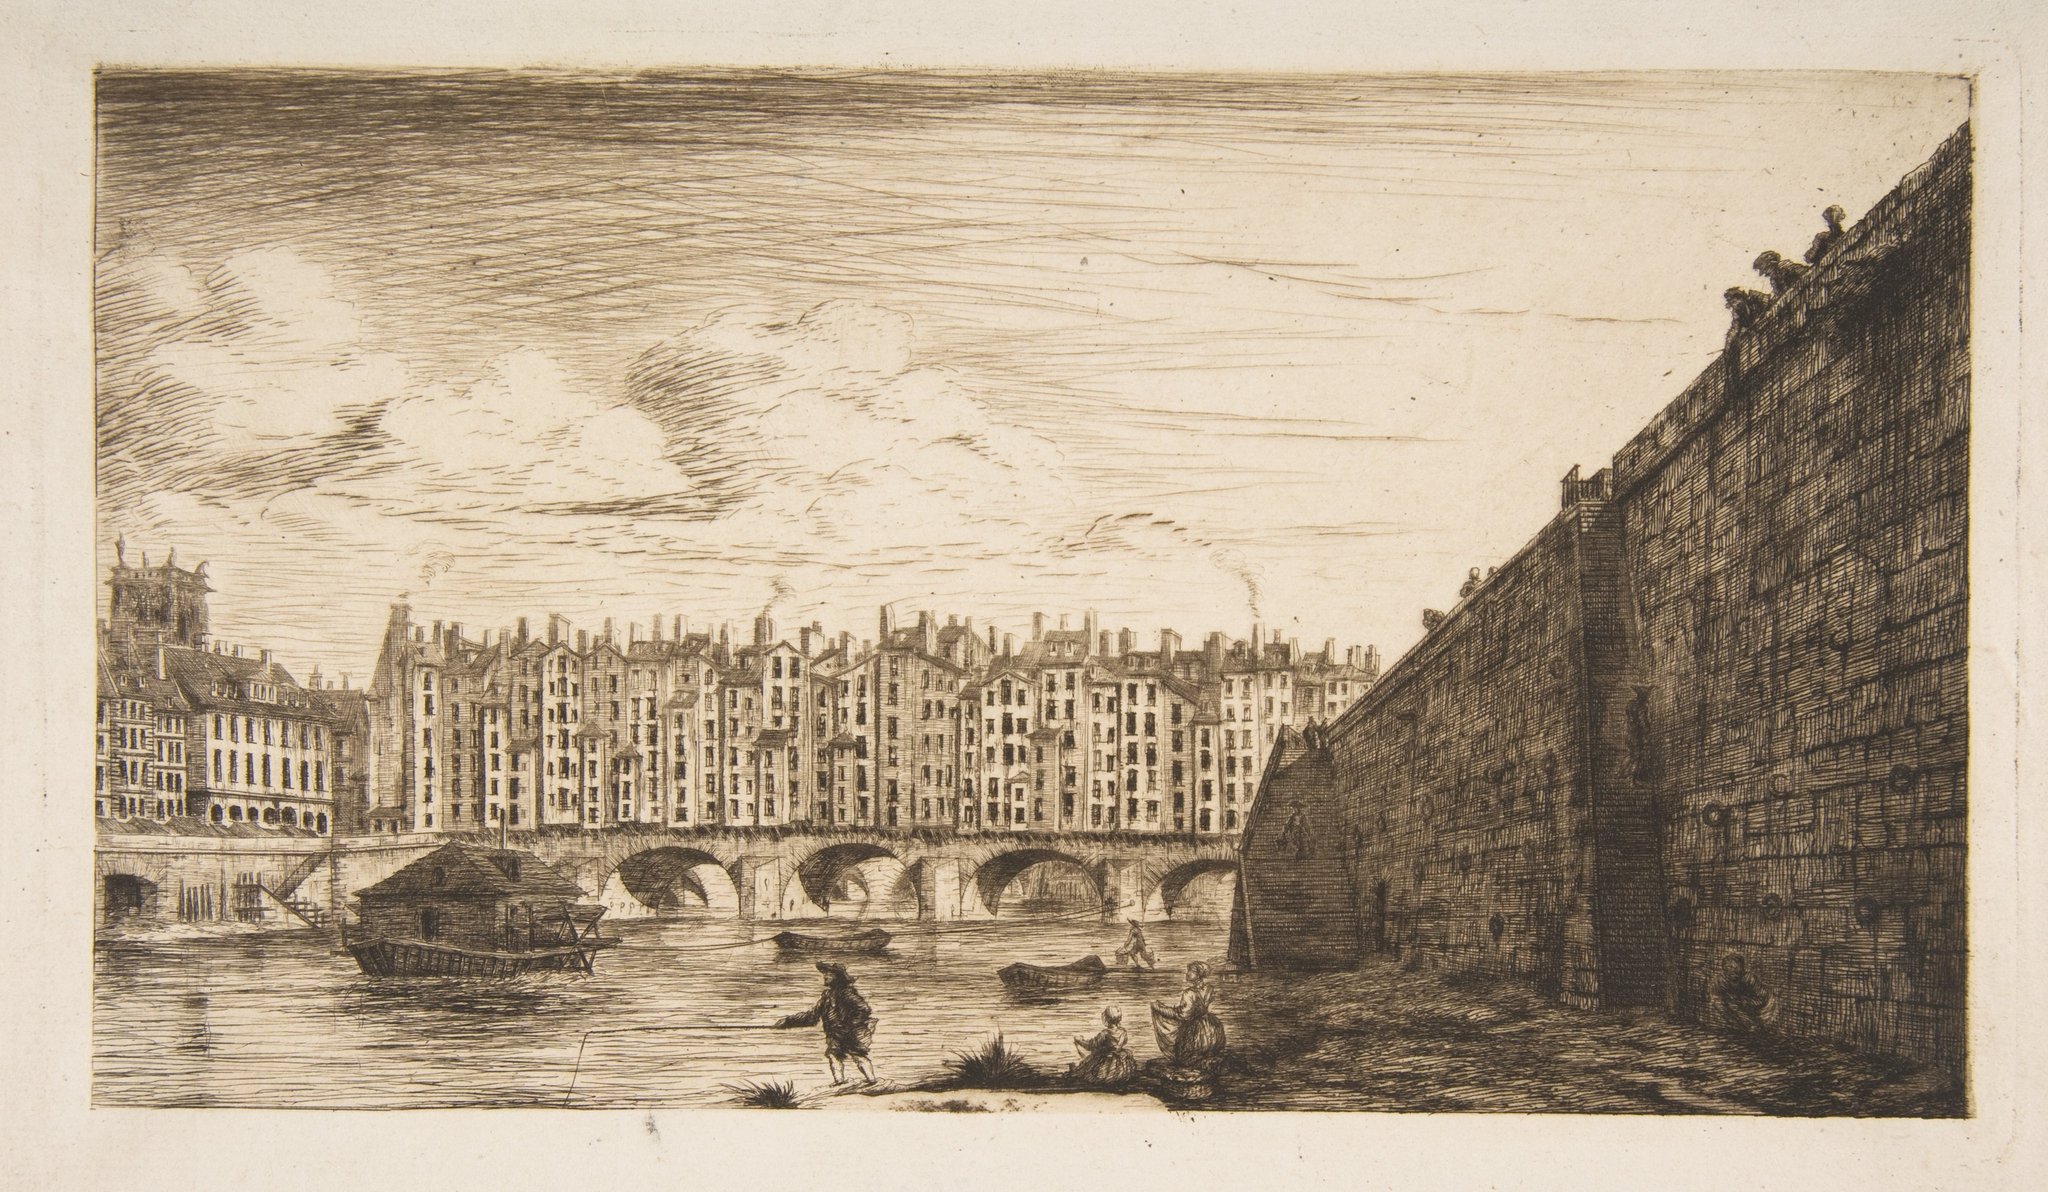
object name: print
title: Le Pont-au-Change, vers 1784 (Pont-au-Change, Paris, circa 1784)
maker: charles meryon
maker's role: artist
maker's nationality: french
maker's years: 1821-1868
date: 1855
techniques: etching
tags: buildings,bridges,boats,paris